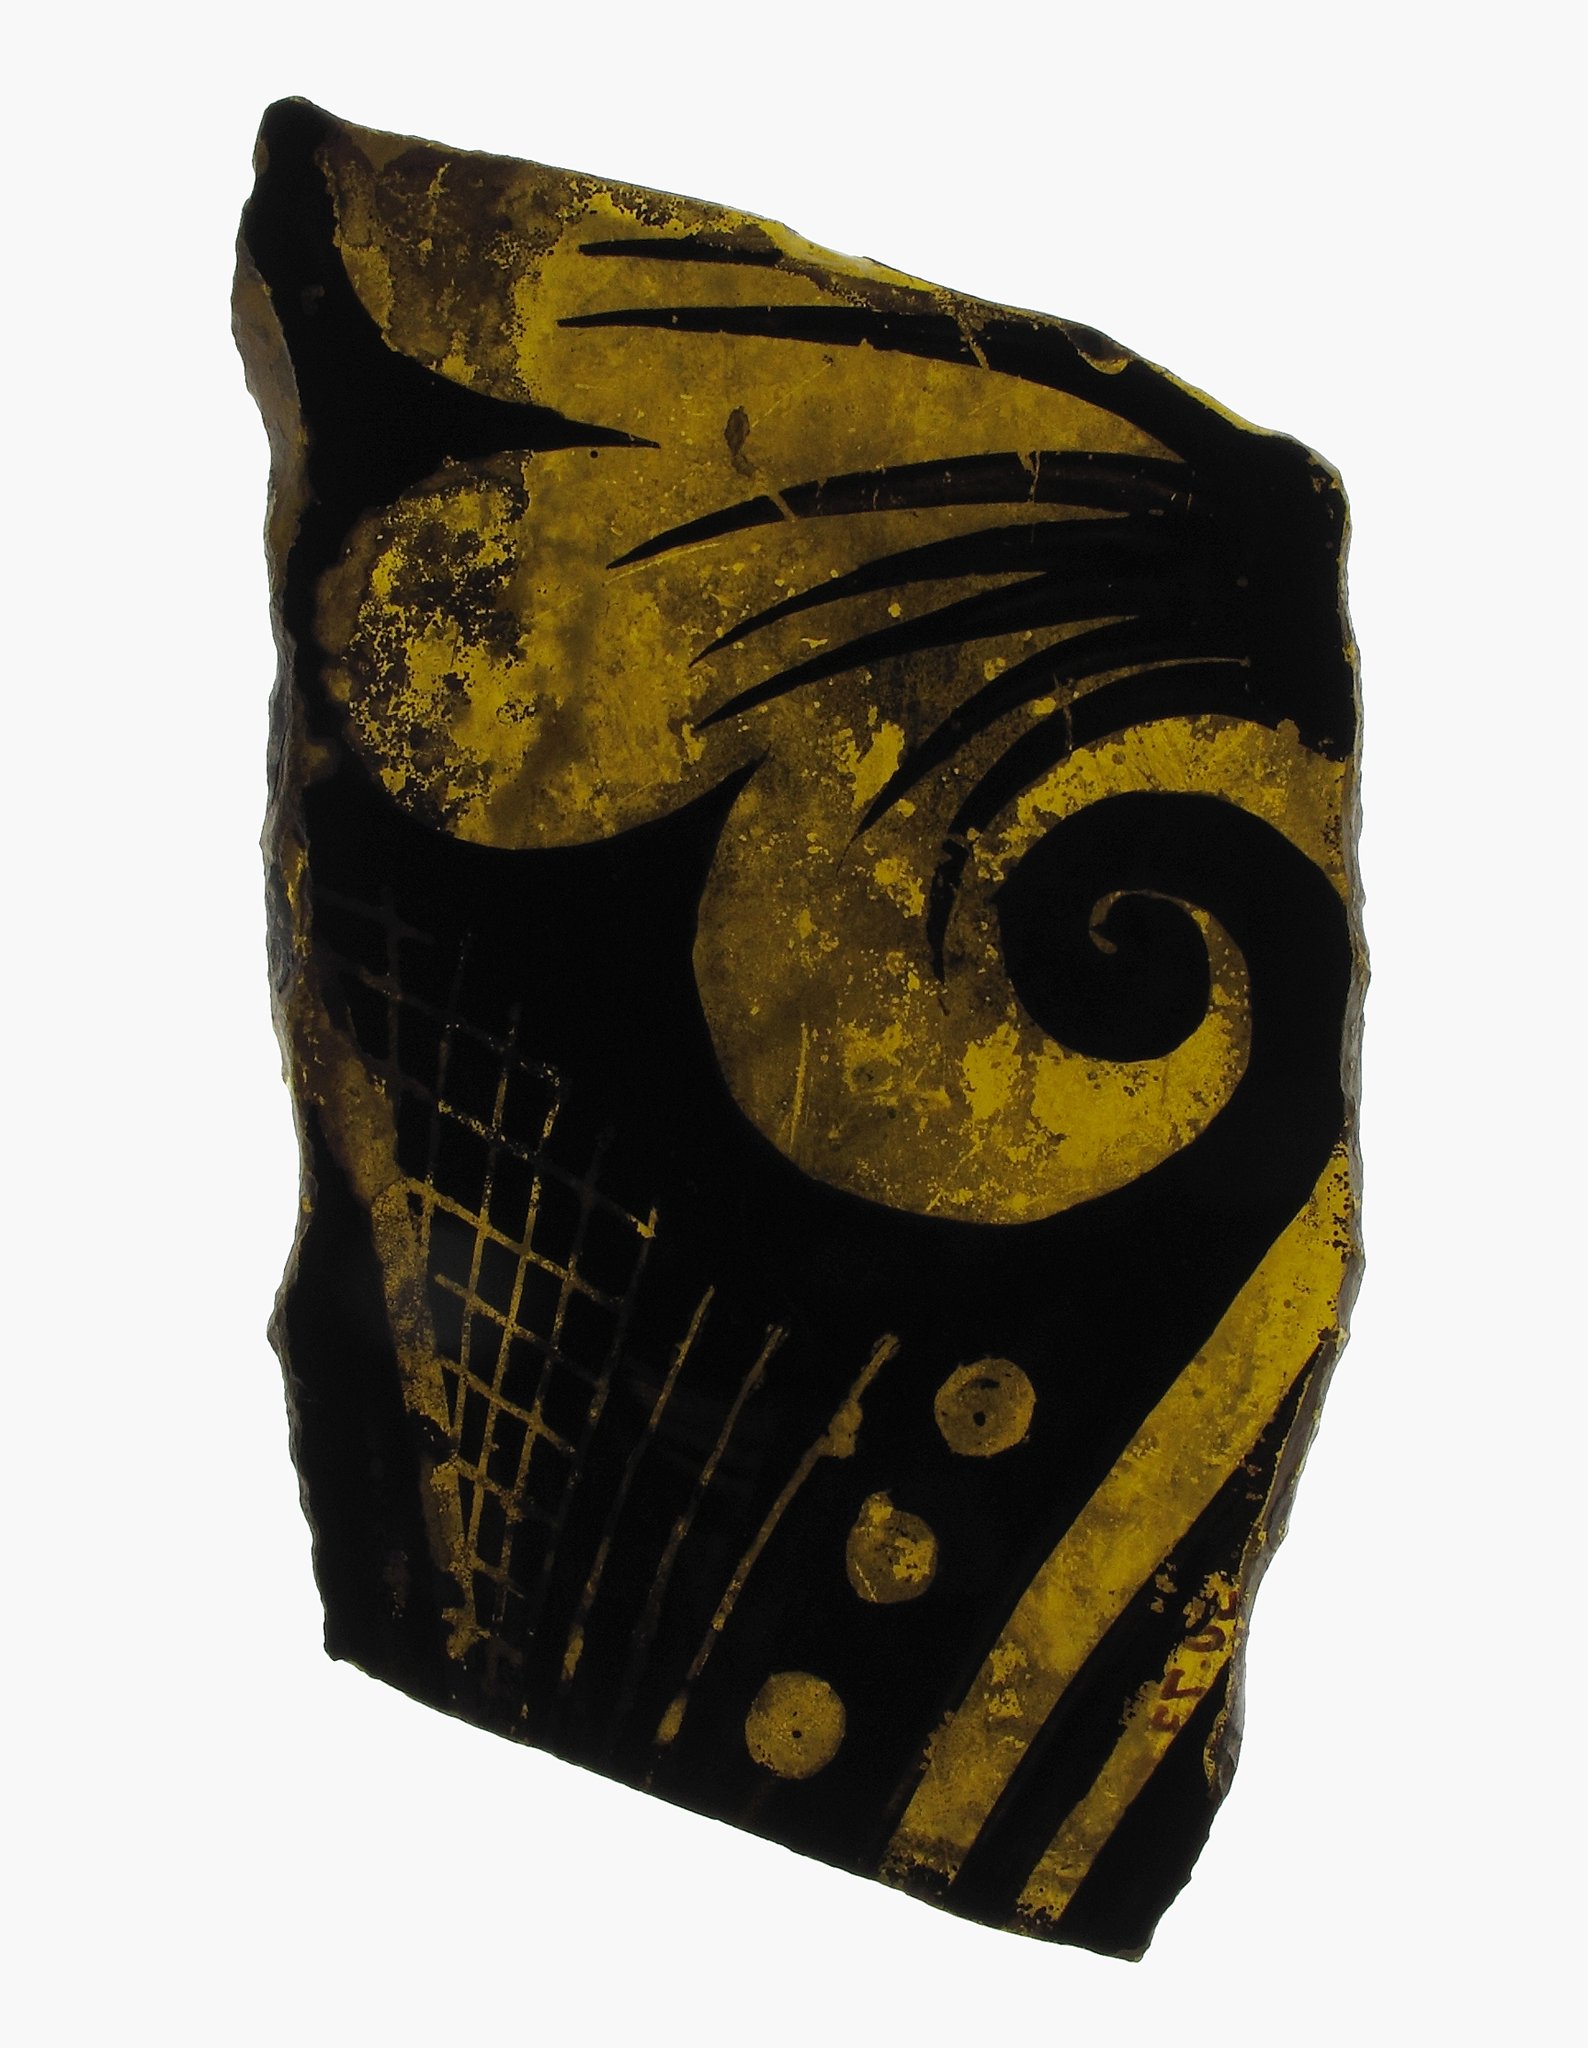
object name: fragment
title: Glass Fragment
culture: french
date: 1101-1200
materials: glass, metal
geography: france